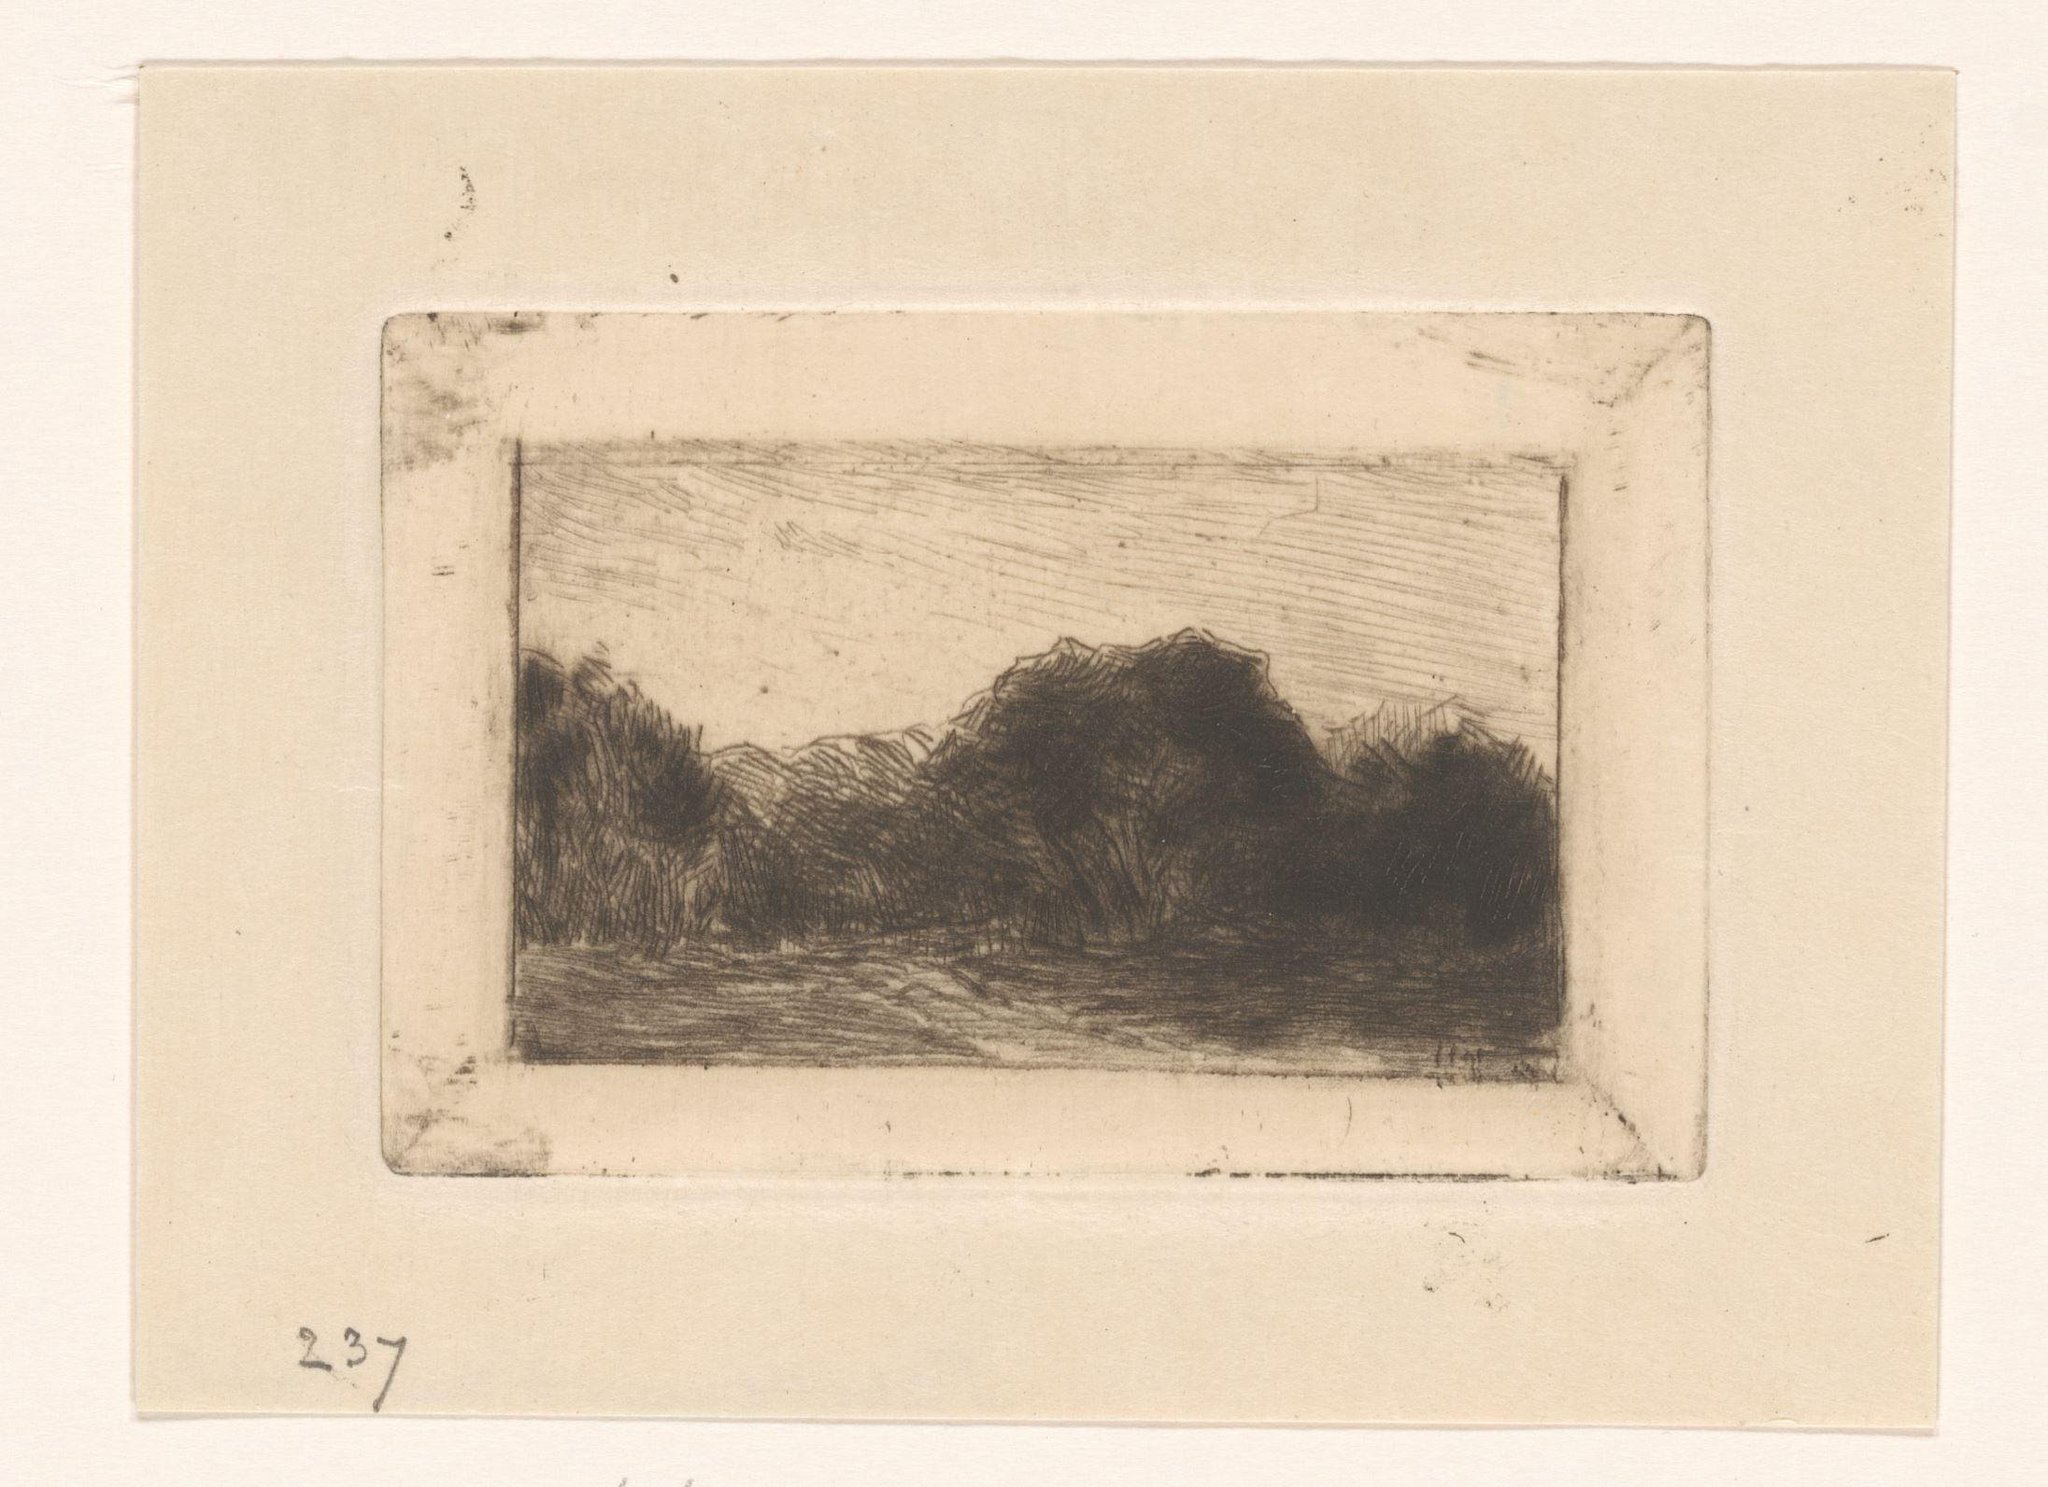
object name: print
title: Boomgroep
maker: carel nicolaas storm van s-gravesande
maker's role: draughtsman, print maker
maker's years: 1841-1924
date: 1851-1887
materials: paper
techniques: drypoint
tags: groups of trees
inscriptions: collector's mark: Lugt 2228